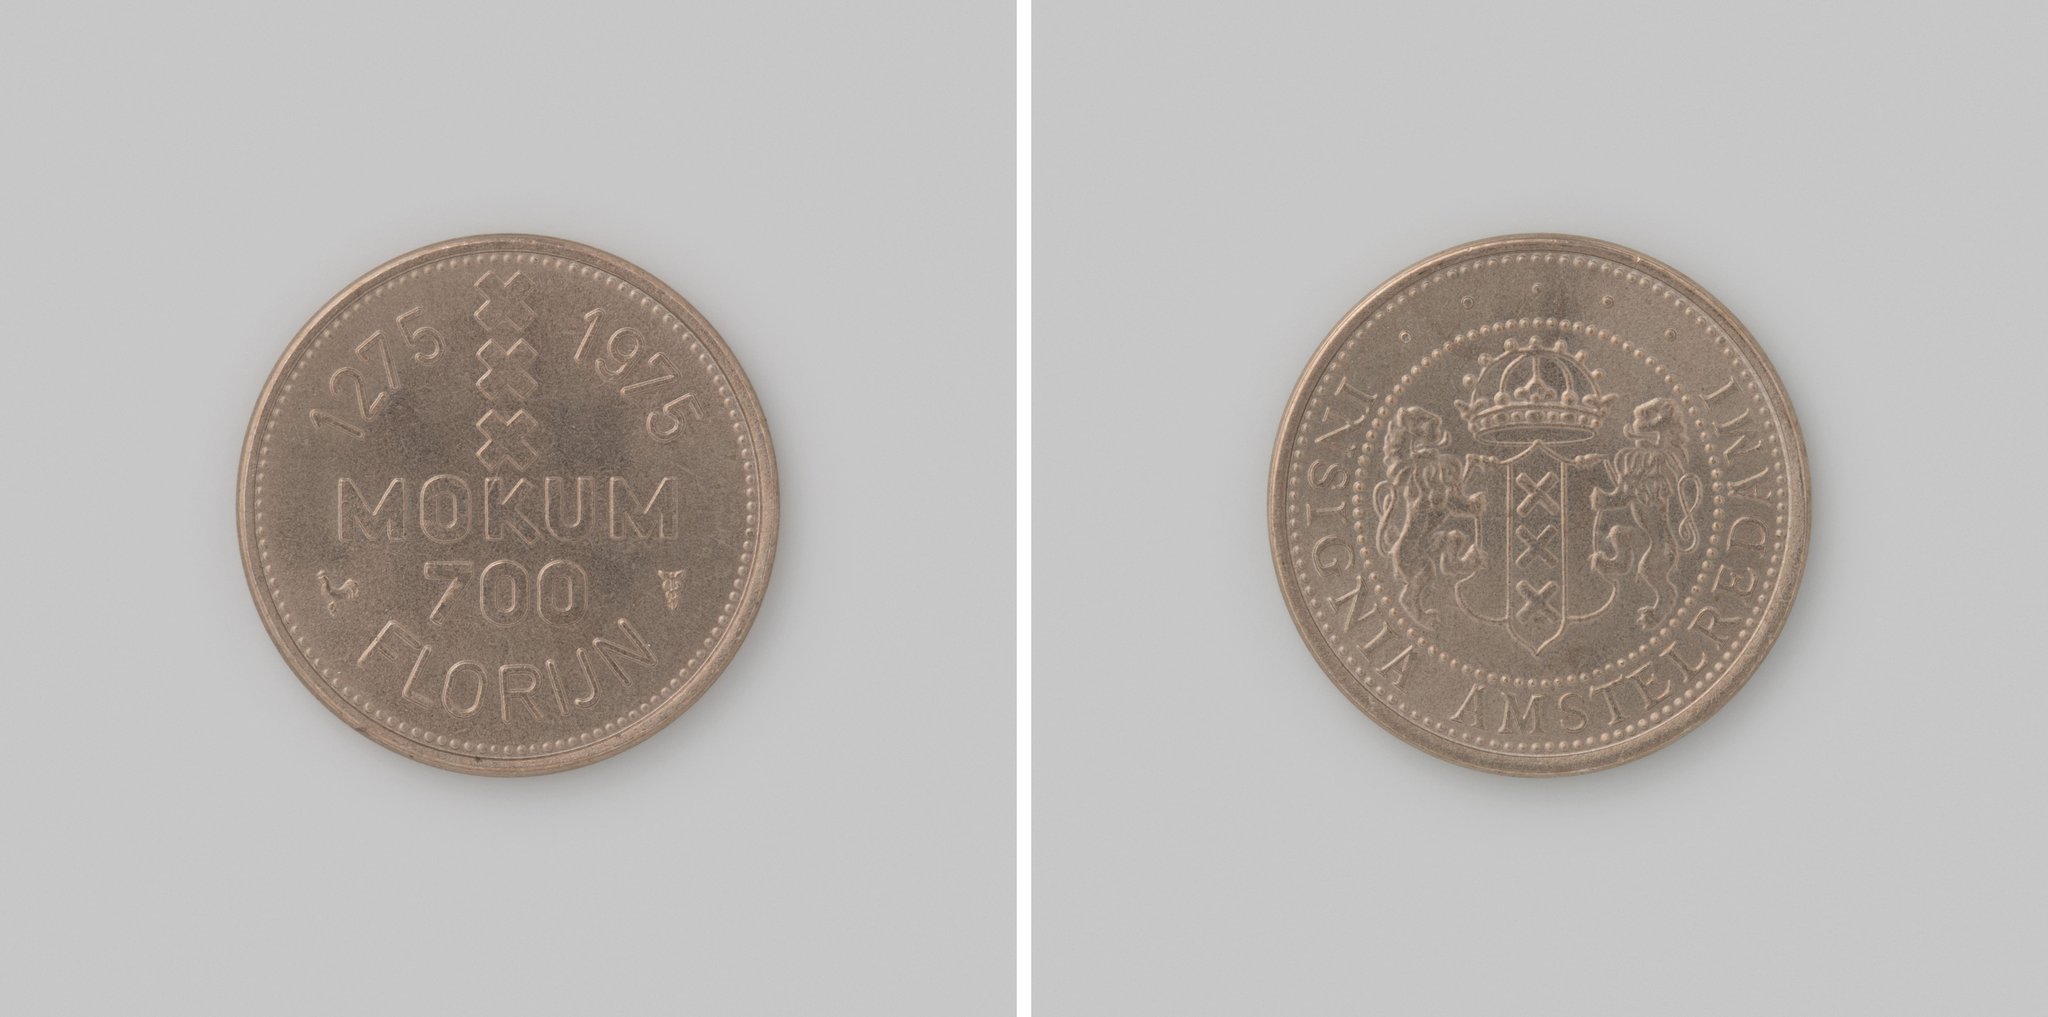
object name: coin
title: Florijn Mokum 700 1275-1975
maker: Anonymous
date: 1975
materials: nickel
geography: netherlands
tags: amsterdam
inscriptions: circumscription: ‘INSIGNIA AMSTELREDAMI’, inscription: ‘1275 1975 / MOKUM 700 / FLORIJN’